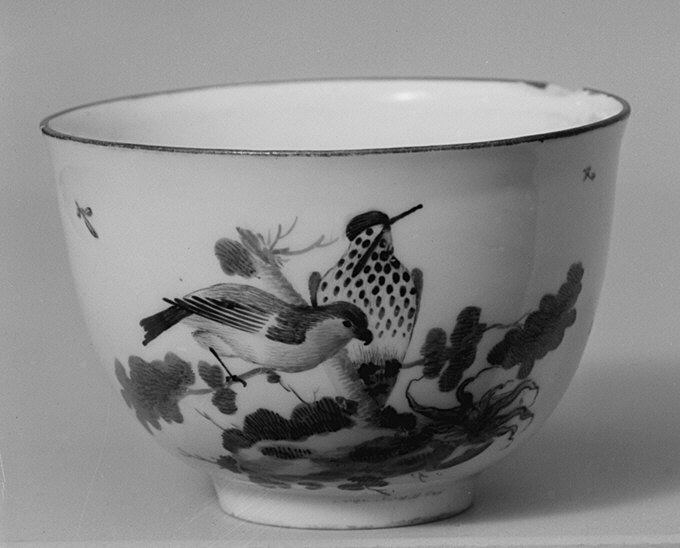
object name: cup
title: Cup (part of a service)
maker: frankenthal porcelain manufactory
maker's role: manufactory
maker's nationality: german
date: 1770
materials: hard paste porcelain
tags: birds